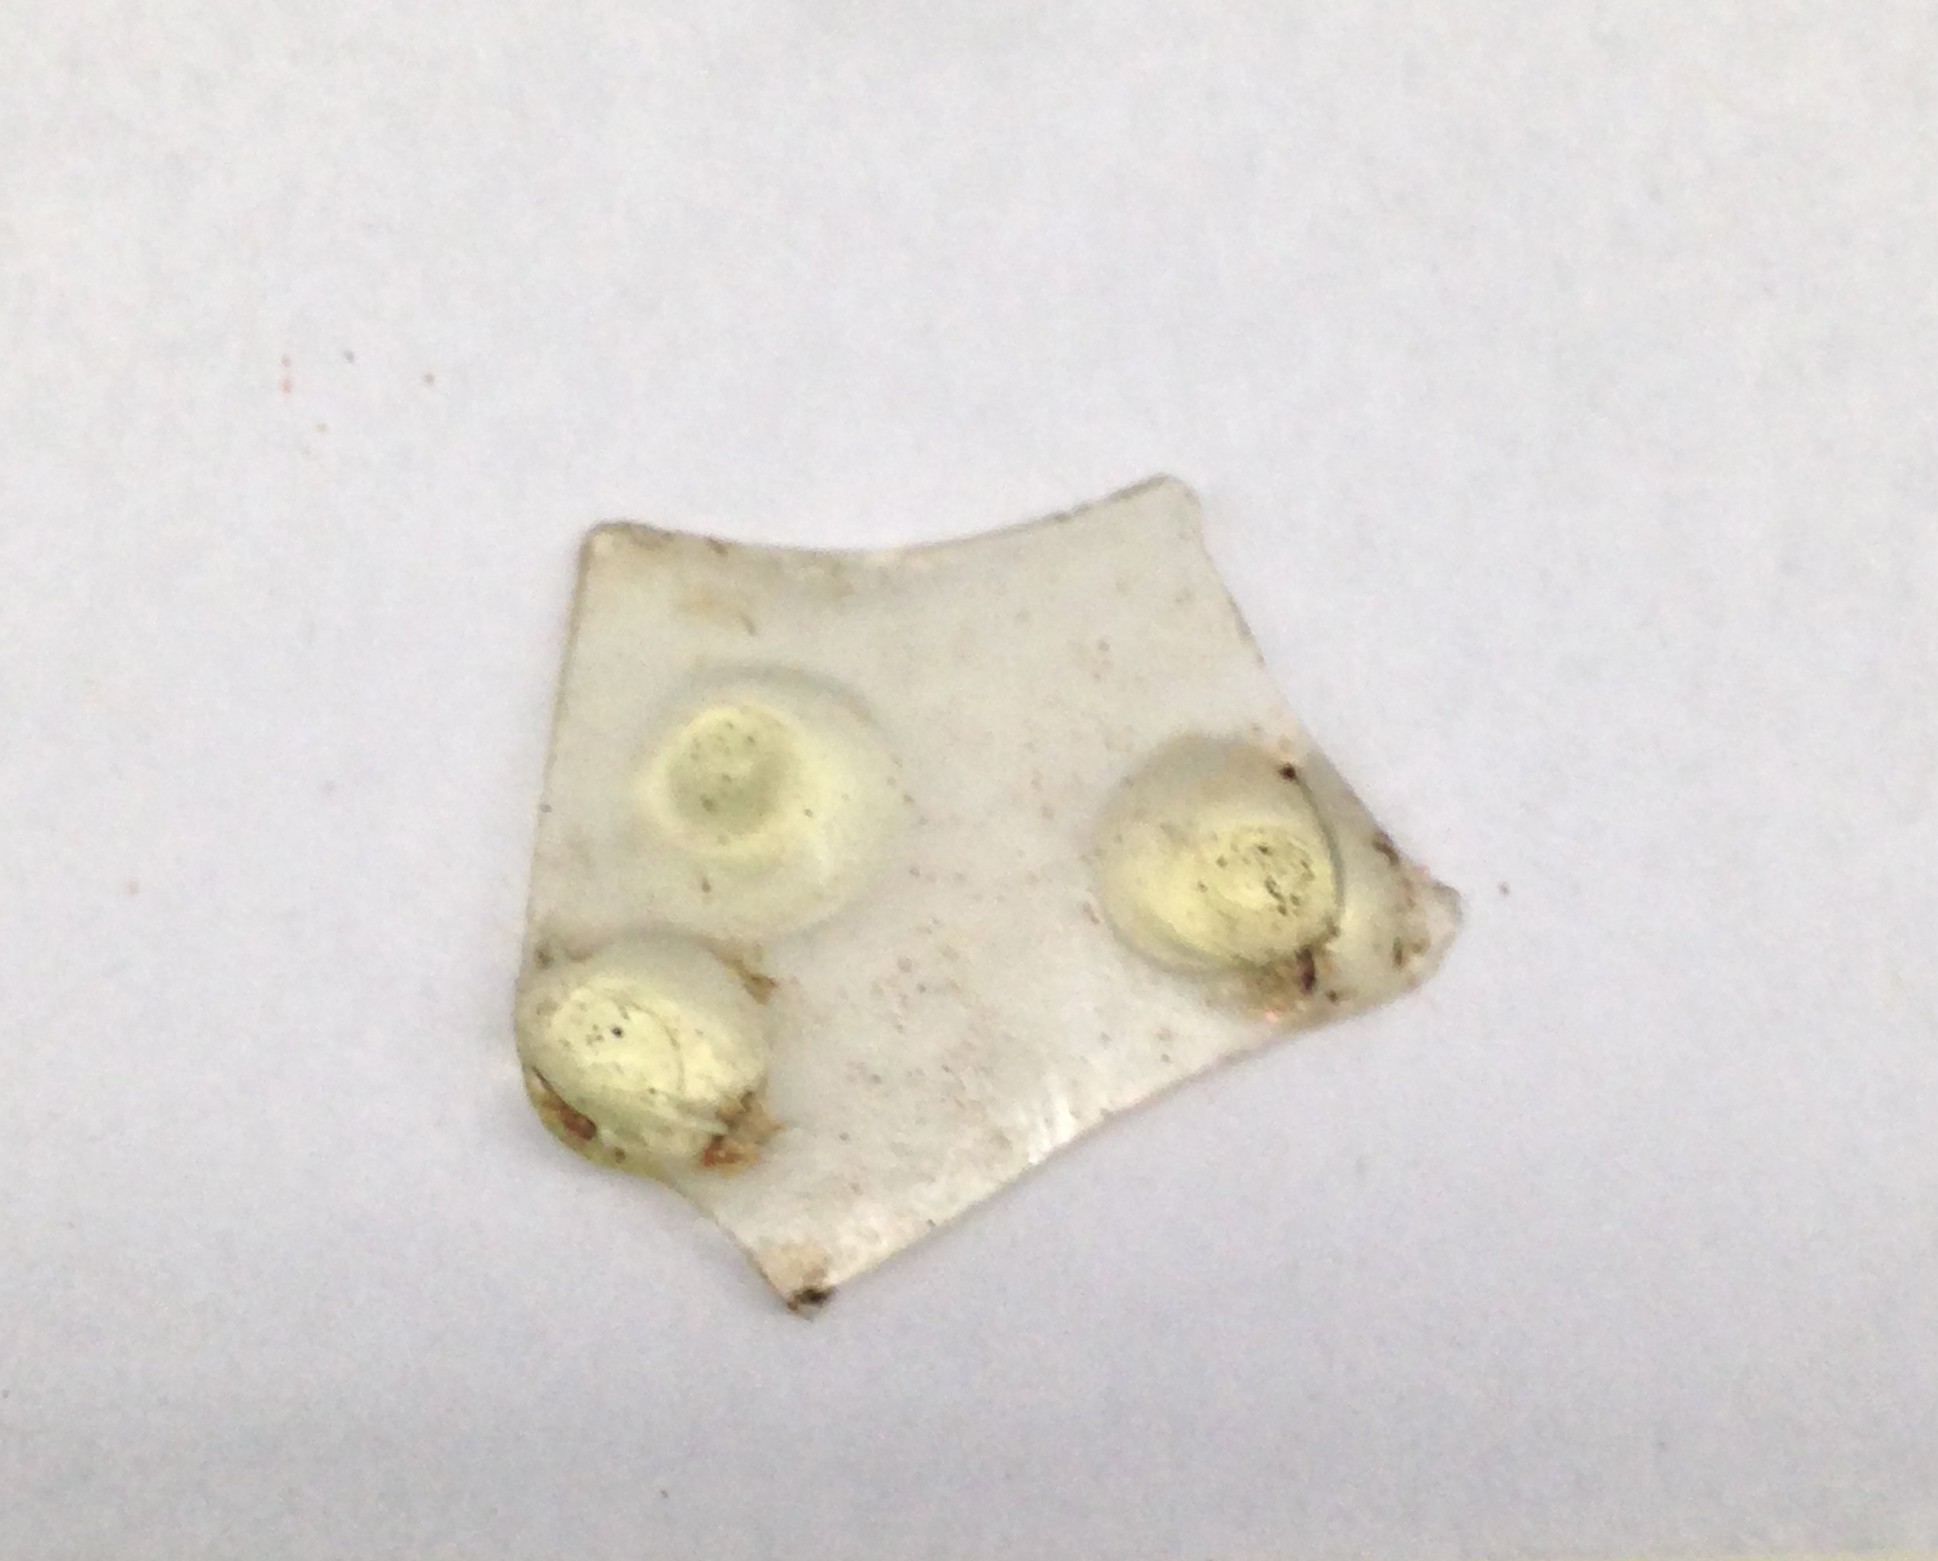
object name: fragment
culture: european or middle eastern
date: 1150-1250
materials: ceramic, glass